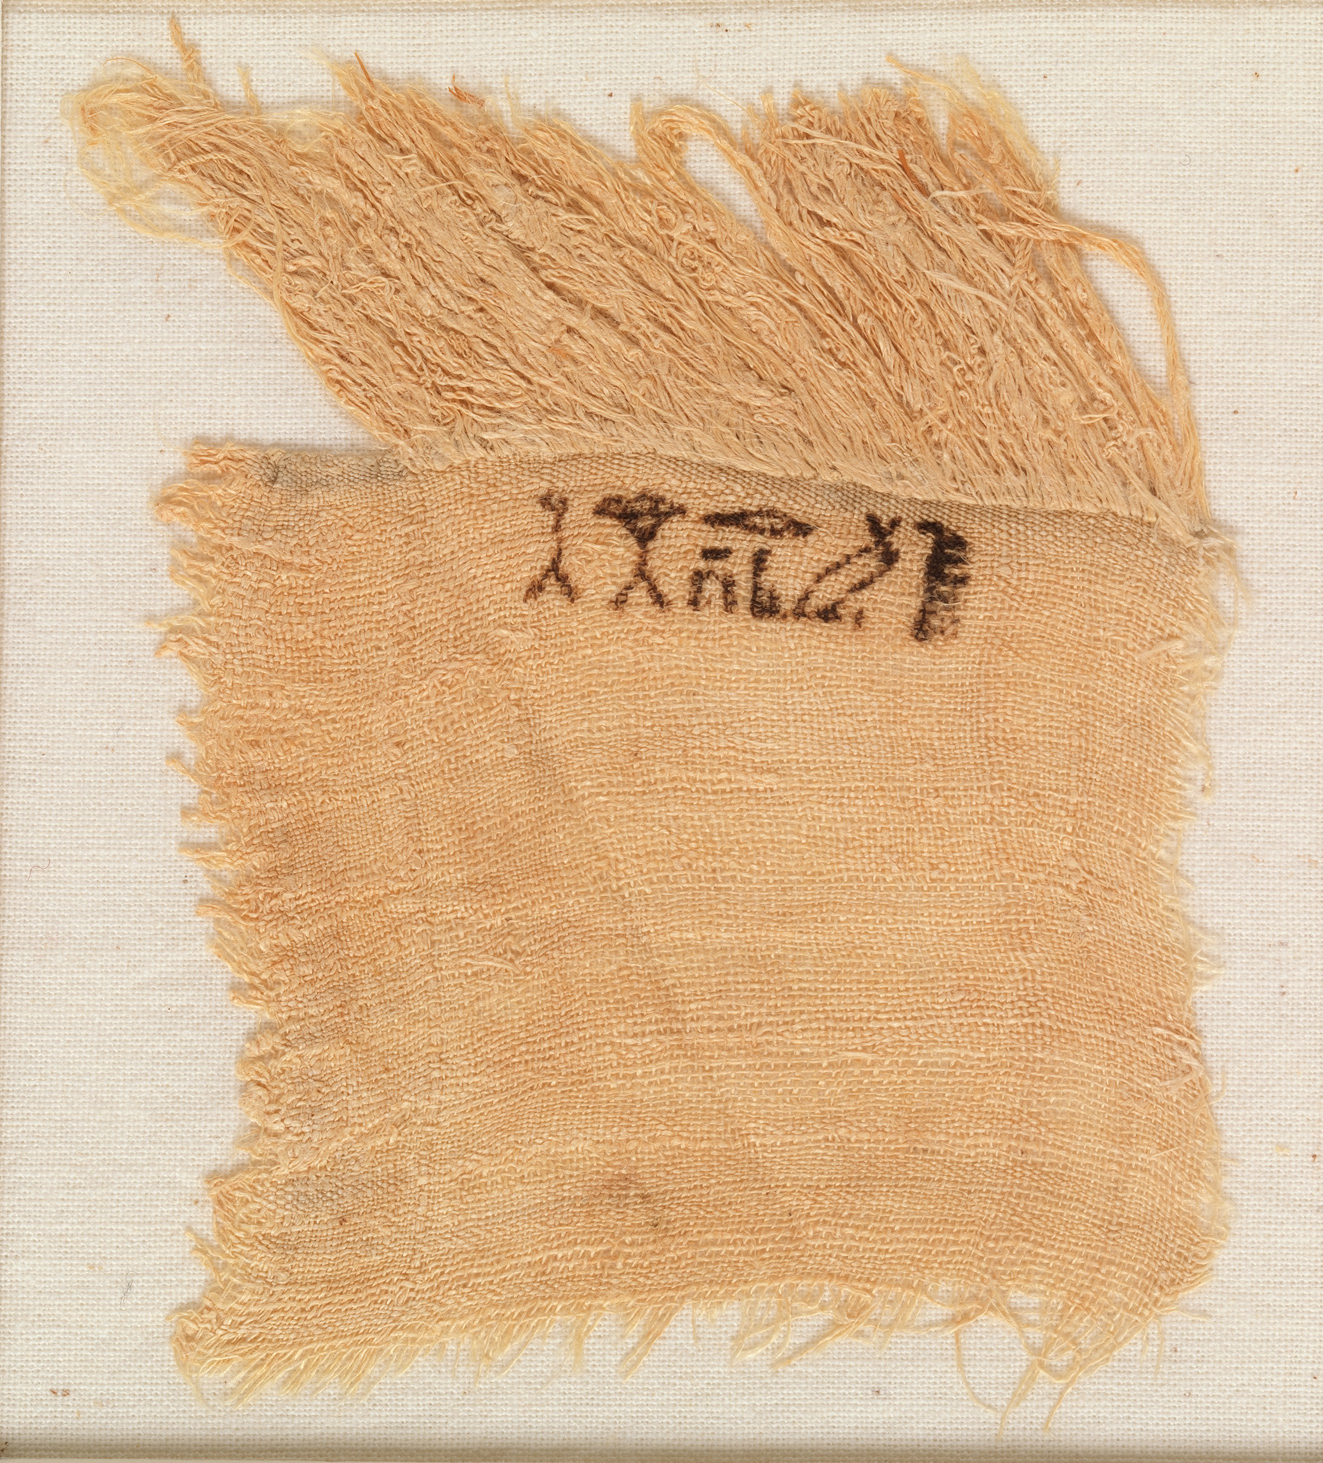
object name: linen mark, wah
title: Linen Mark found in Wrappings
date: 1981-1975 BCE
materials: linen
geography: egypt